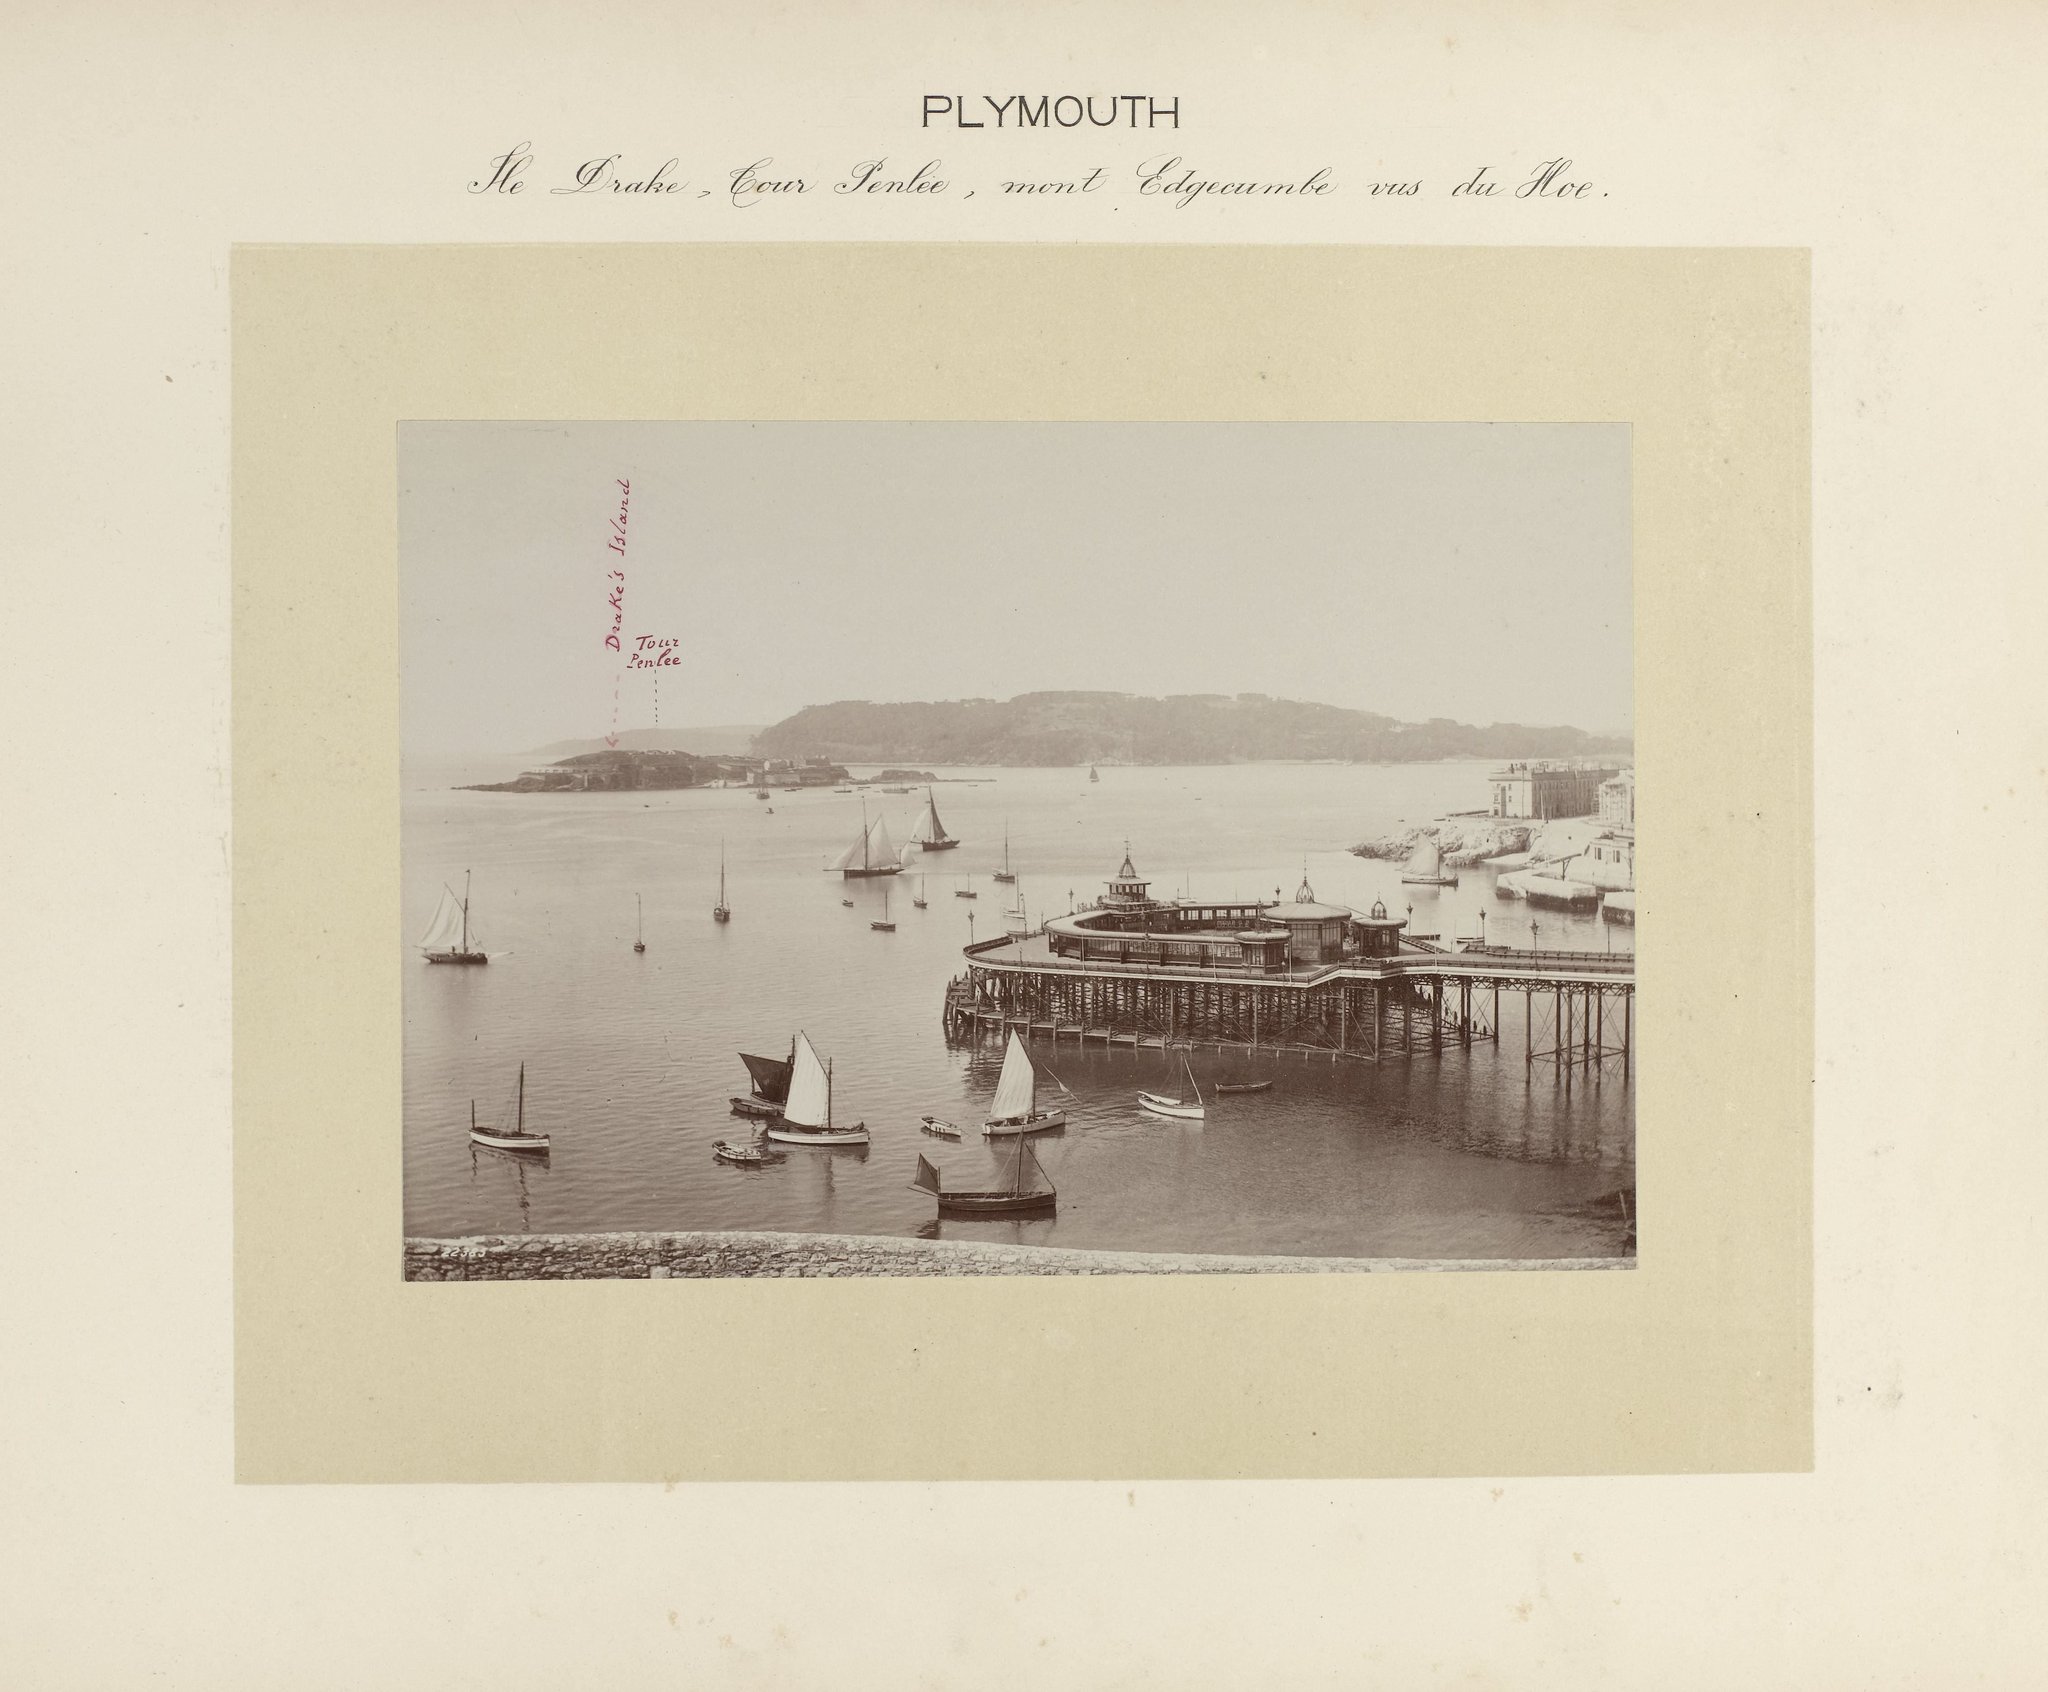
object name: photograph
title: Angleterre. Défense des côtes. Reconaissance de 1891. Photographies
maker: Anonymous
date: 1891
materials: cardboard, paper, photographic support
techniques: albumen print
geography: great britain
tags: plymouth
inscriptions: inscription: ‘PLYMOUTH / Ile Drake, Cour Penlee, mont Edgecumbe vus du Hoe.’, annotation: ‘Drake's Island // Tour Penlee’, inscription: ‘22385’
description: Foto uit een album met 35 topografische foto's van Britse kustplaatsen, waarop in pen militaire verdedigingswerken zijn aangegeven door een Franse militair.